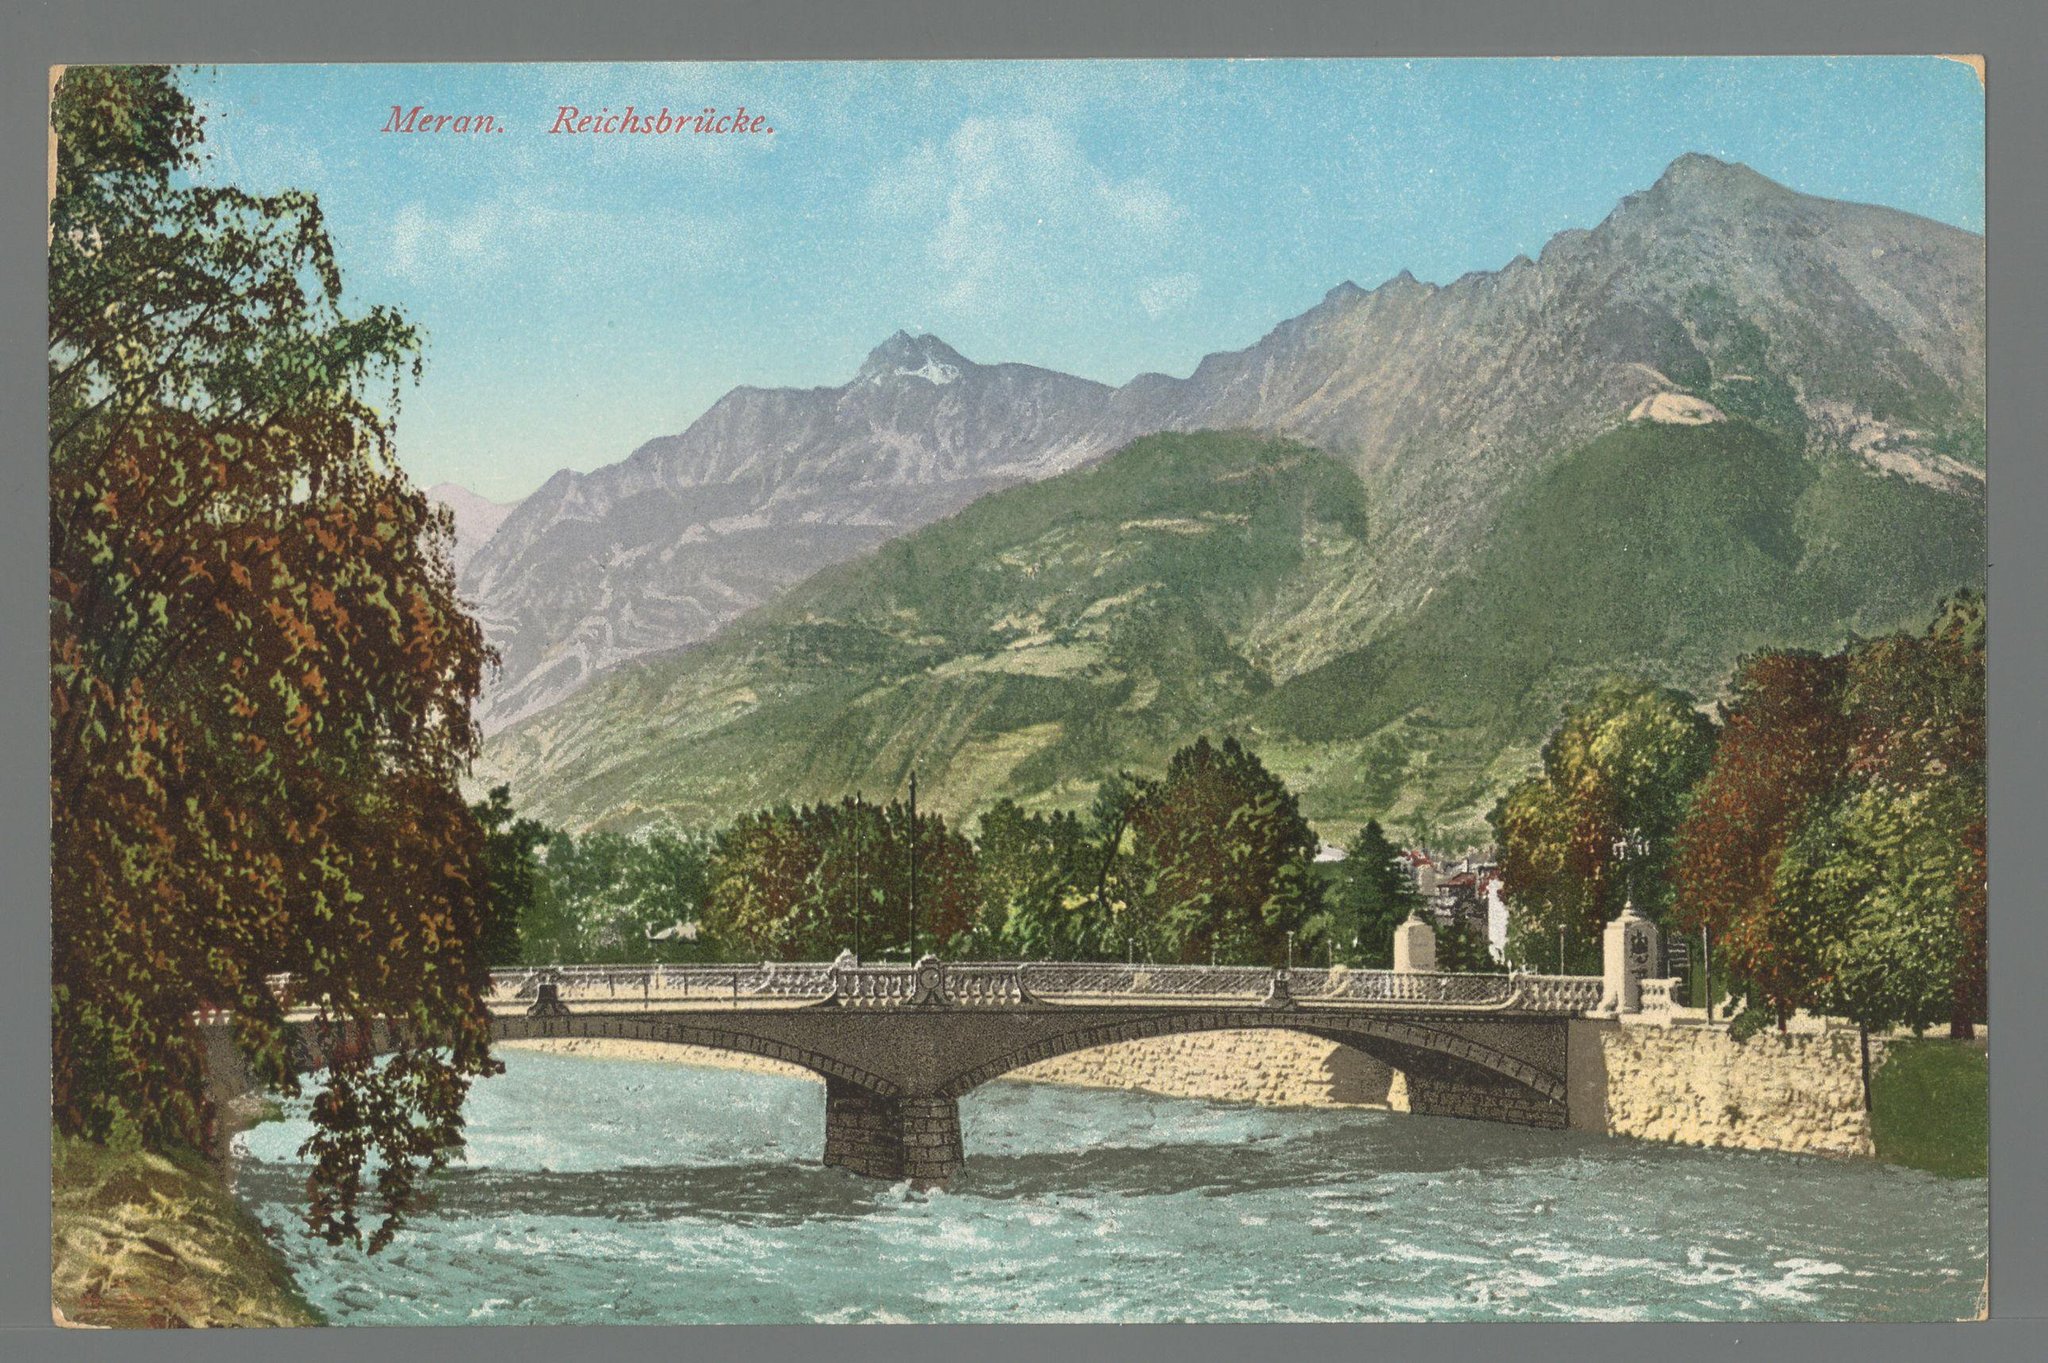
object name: ansichtkaart, prentbriefkaart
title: Meran. Reichsbrücke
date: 1906-1930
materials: cardboard, photographic process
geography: merano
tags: landscapes with waters, waterscapes, seascapes (in the temperate zone), bridge, mountains